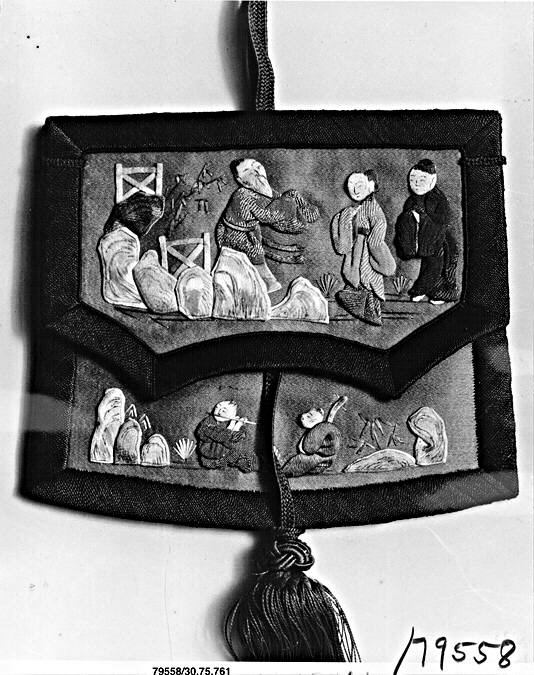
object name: bag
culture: chinese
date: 1701-1900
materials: silk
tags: men,flutes